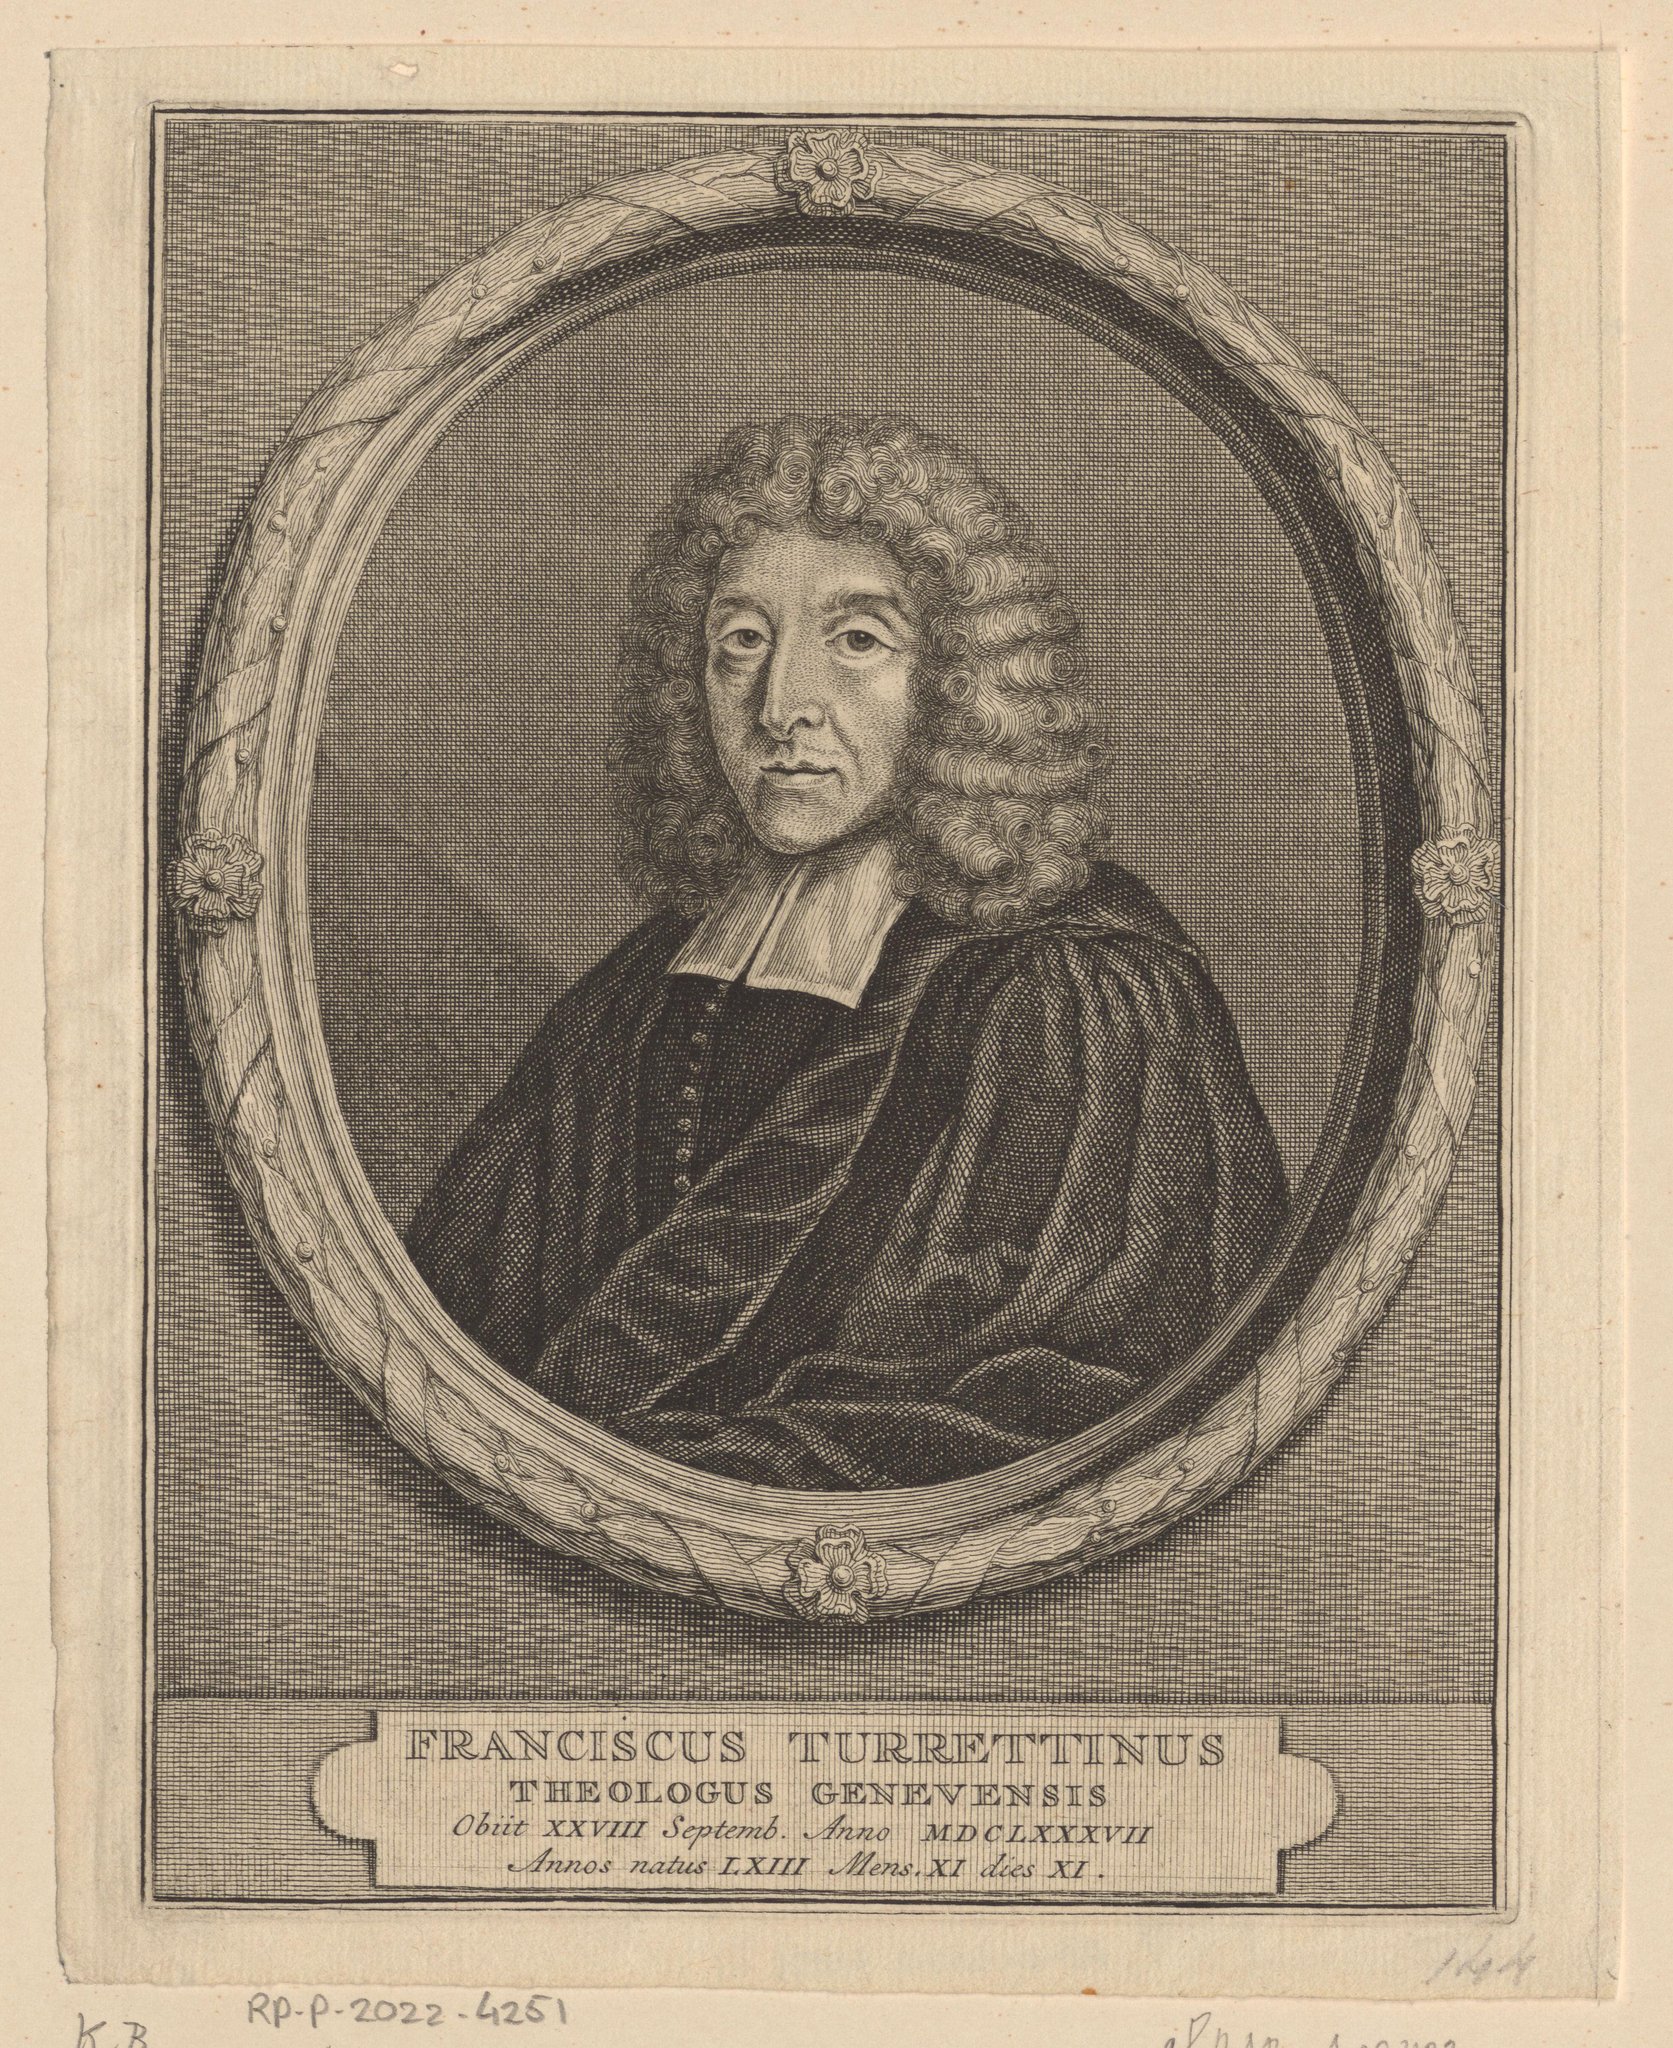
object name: print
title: Portret van Franciscus Turrettinus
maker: Anonymous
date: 1734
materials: paper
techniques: engraving, etching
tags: theologian, historical persons, portrait of a writer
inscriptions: collector's mark: Lugt 240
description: Prent waarschijnlijk uit: Turrettinus, Franciscus. Institutio theologiæ elencticæ (...). Utrecht: Jacob van Poolsum, 1734.